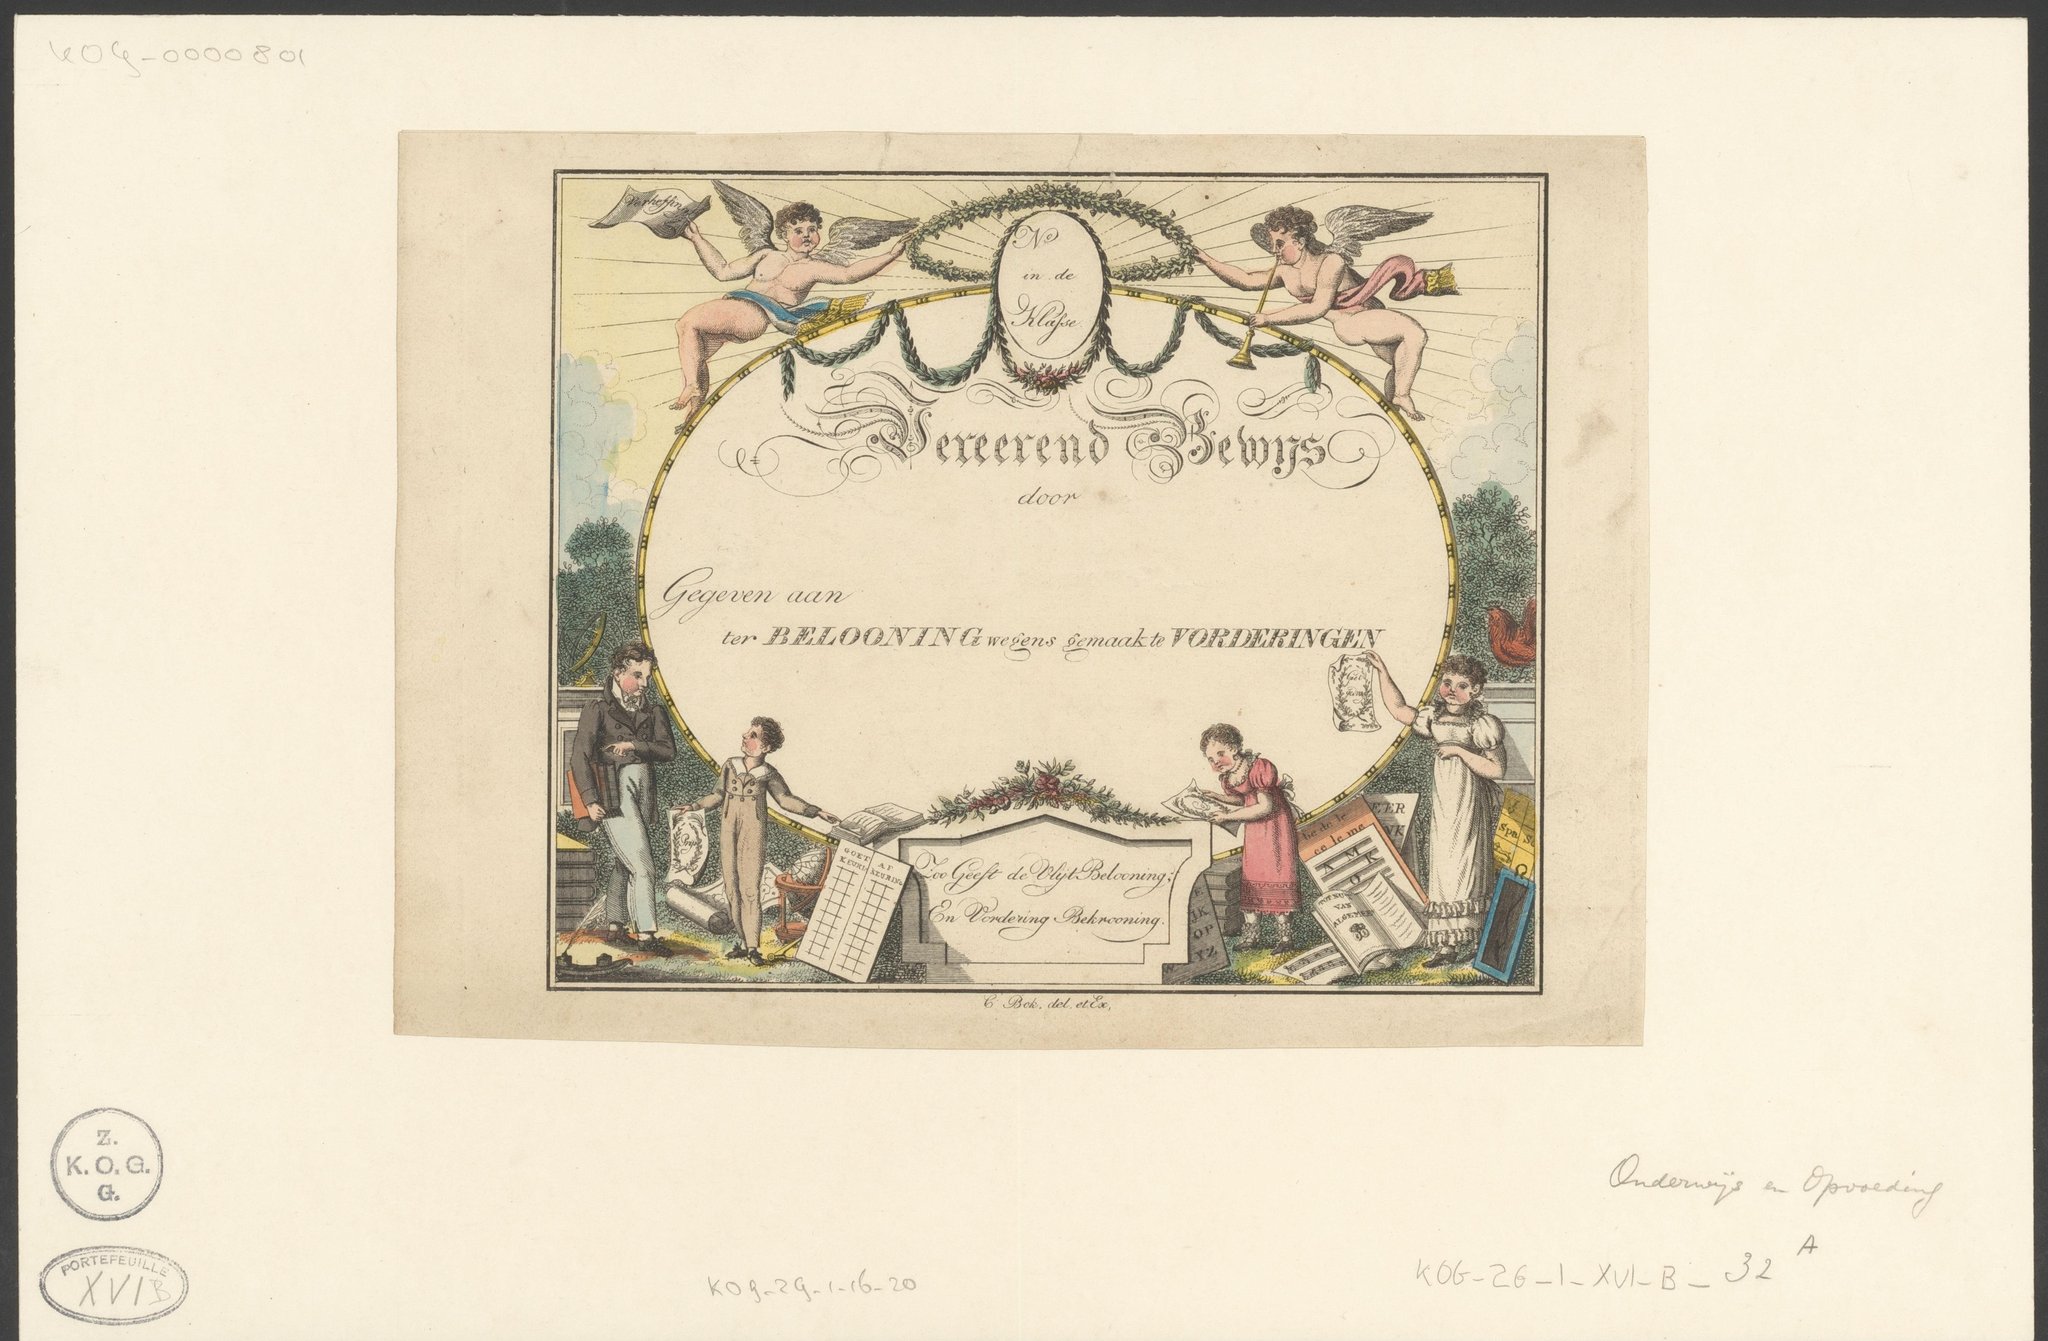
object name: print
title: Beloning voor gemaakte vorderingen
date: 1700-1799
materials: paper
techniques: engraving, etching, hand coloring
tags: reading, education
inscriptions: collector's mark: Lugt 1641, stamp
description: Bewijs en beloning voor gemaakte vorderingen in de klas. Voorgedrukt briefje versierd met putti, lerende kinderen en leerboeken met open delen die met de pen kunnen worden ingevuld. Bovenaan kan worden aangegeven wel nummer van de klas het kind is. Onderwerpsrubrieken binnen de Atlas Zeden en Gewoonten: Onderwijs en Wetenschappen, Opvoeding en Onderwijs, Schoolmeesters.